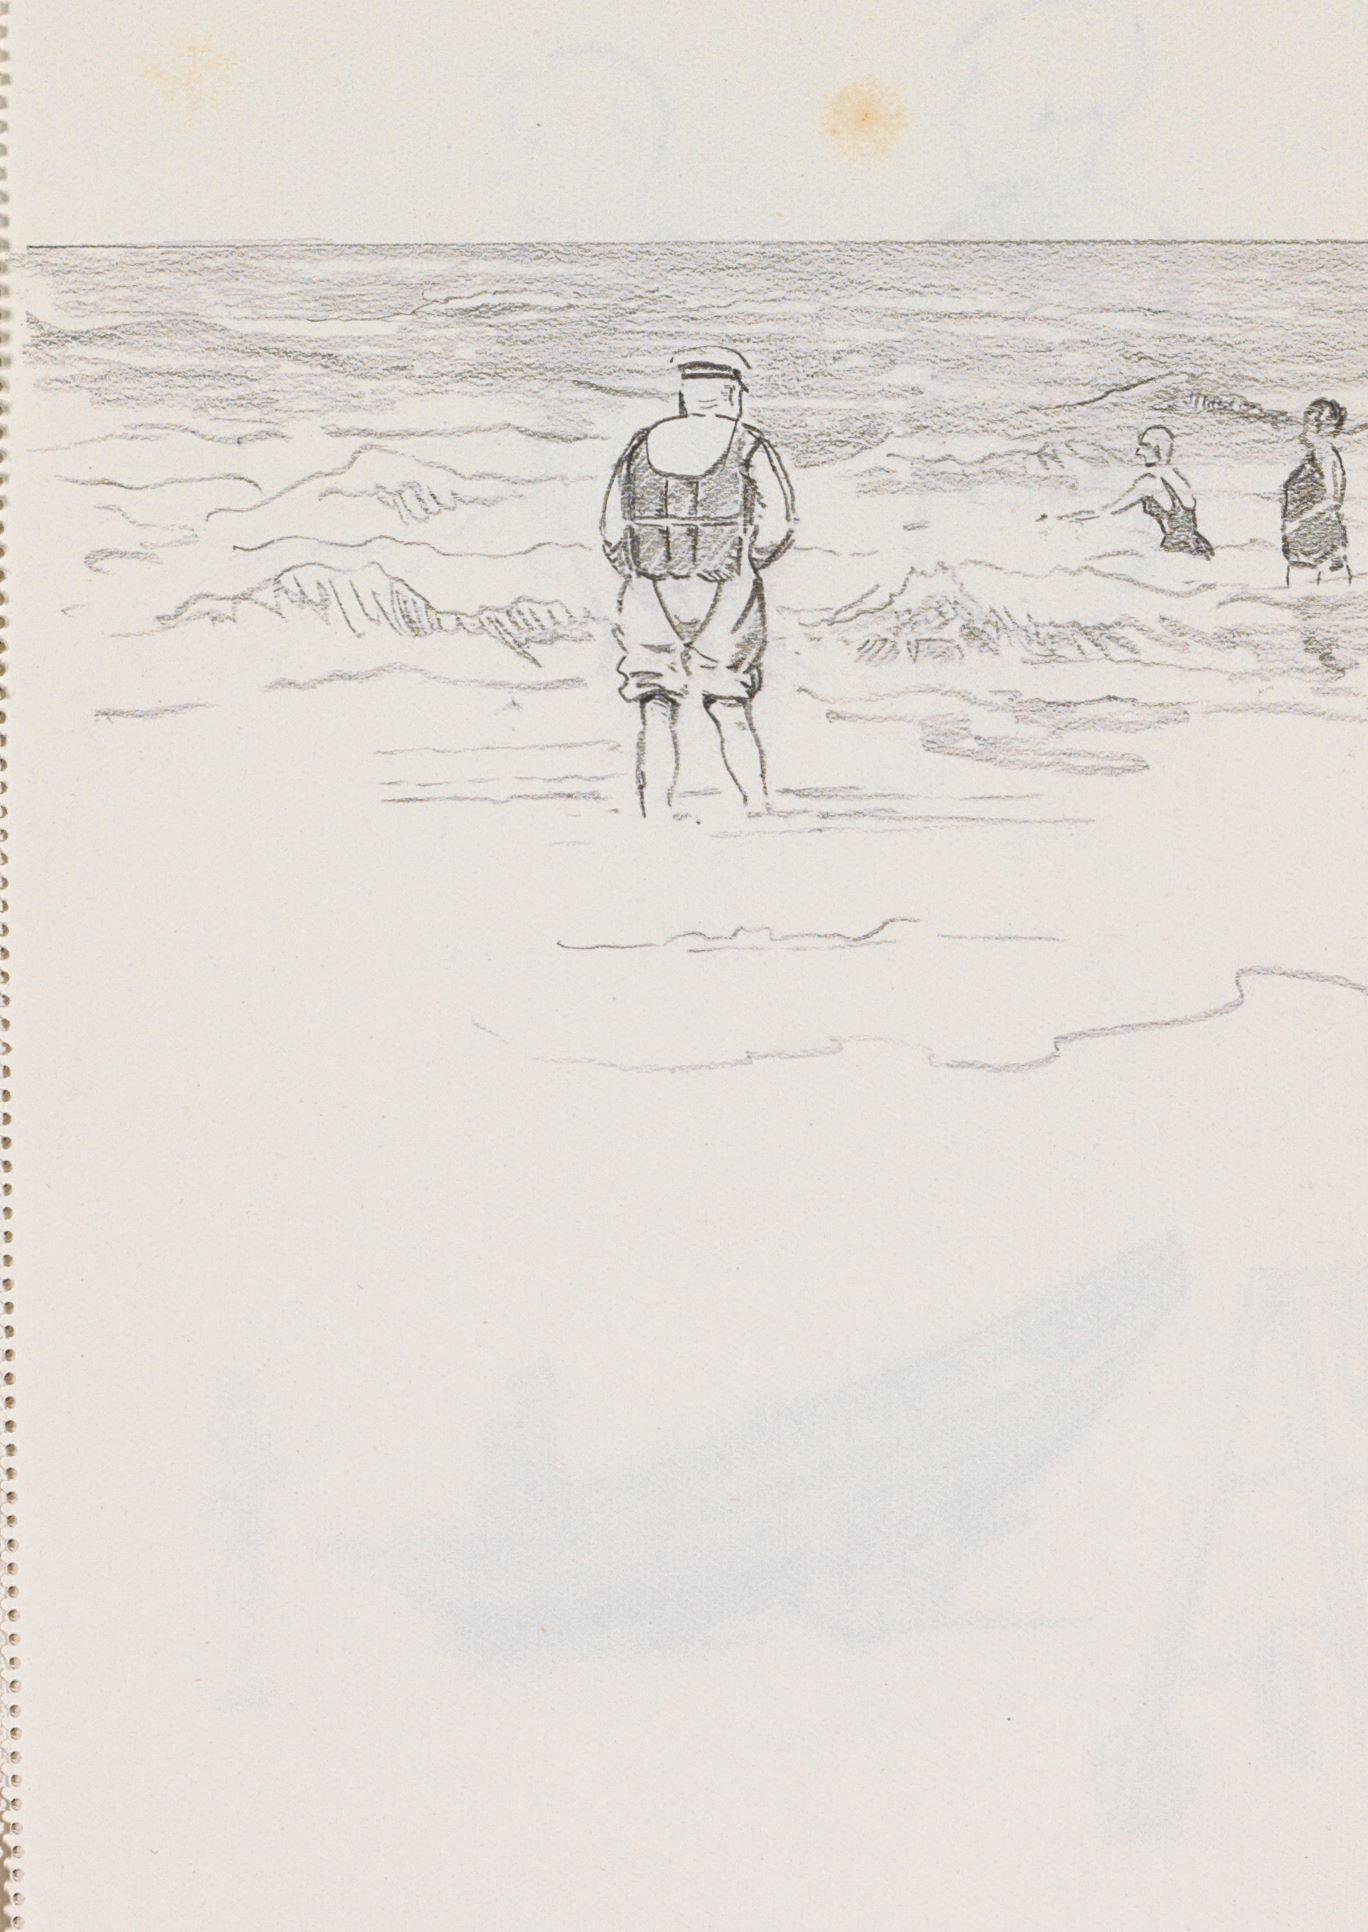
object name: sketchbook leaf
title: Drie zwemmers in zee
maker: otto verhagen (i)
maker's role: draughtsman, print maker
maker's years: 1885-1951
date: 1930-1940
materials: chalk, paper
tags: sea (seascape), in or beside the water (on the beach)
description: Op de voorgrond staat een man met een zwemvest tot aan zijn enkels in zee. Pagina 36 uit een schetsboek met 60 bladen.